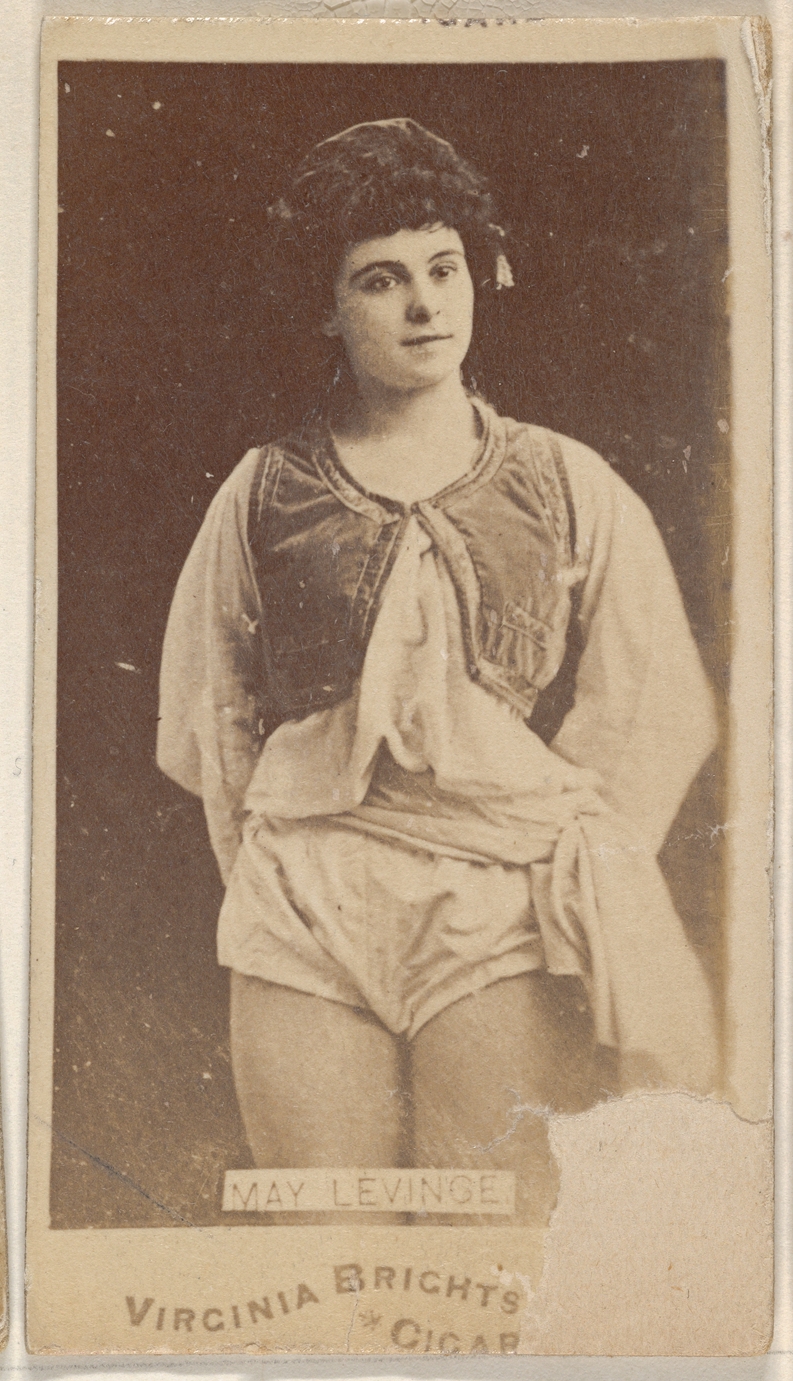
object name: photograph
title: May Levinge, from the Actors and Actresses series (N45, Type 1) for Virginia Brights Cigarettes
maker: allen & ginter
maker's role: publisher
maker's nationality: american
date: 1888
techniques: albumen silver print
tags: portraits,women,actresses